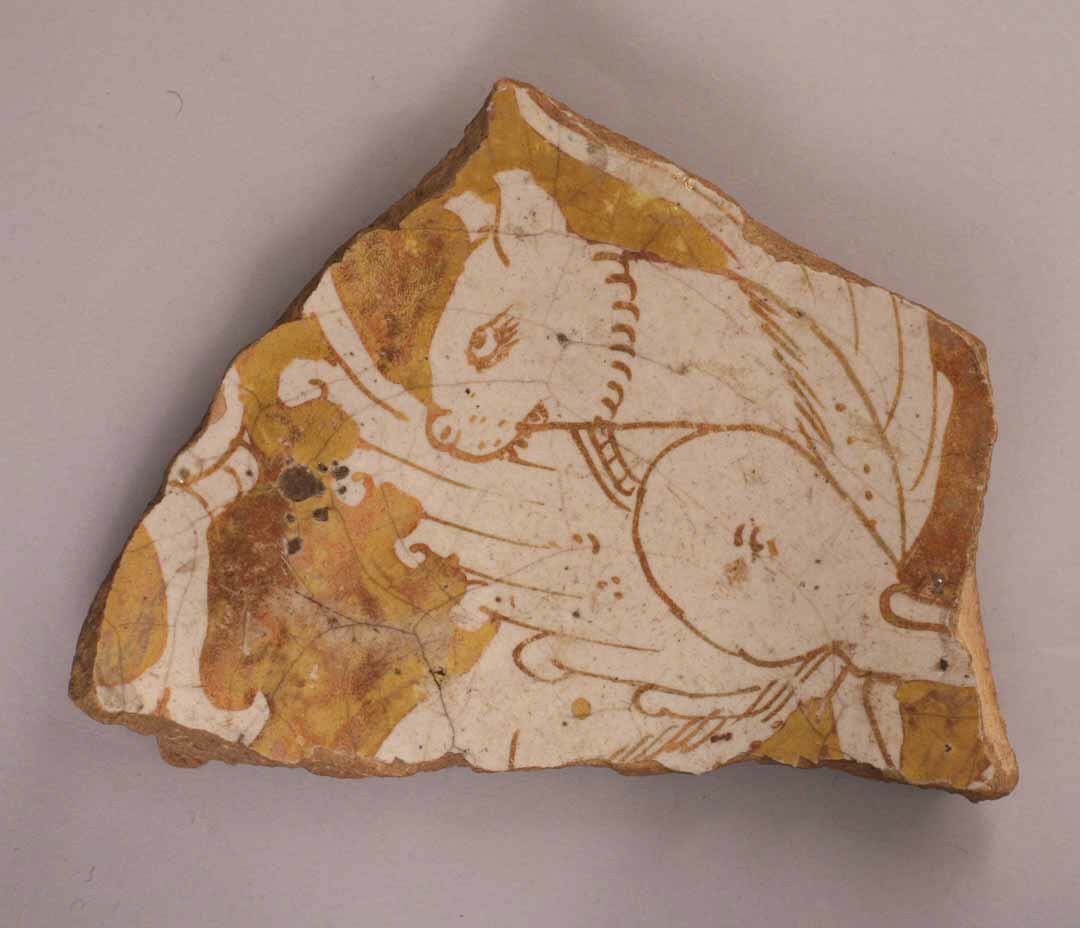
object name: fragment of a bowl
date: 901-1200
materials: glaze, stonepaste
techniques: painting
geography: egypt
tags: animals